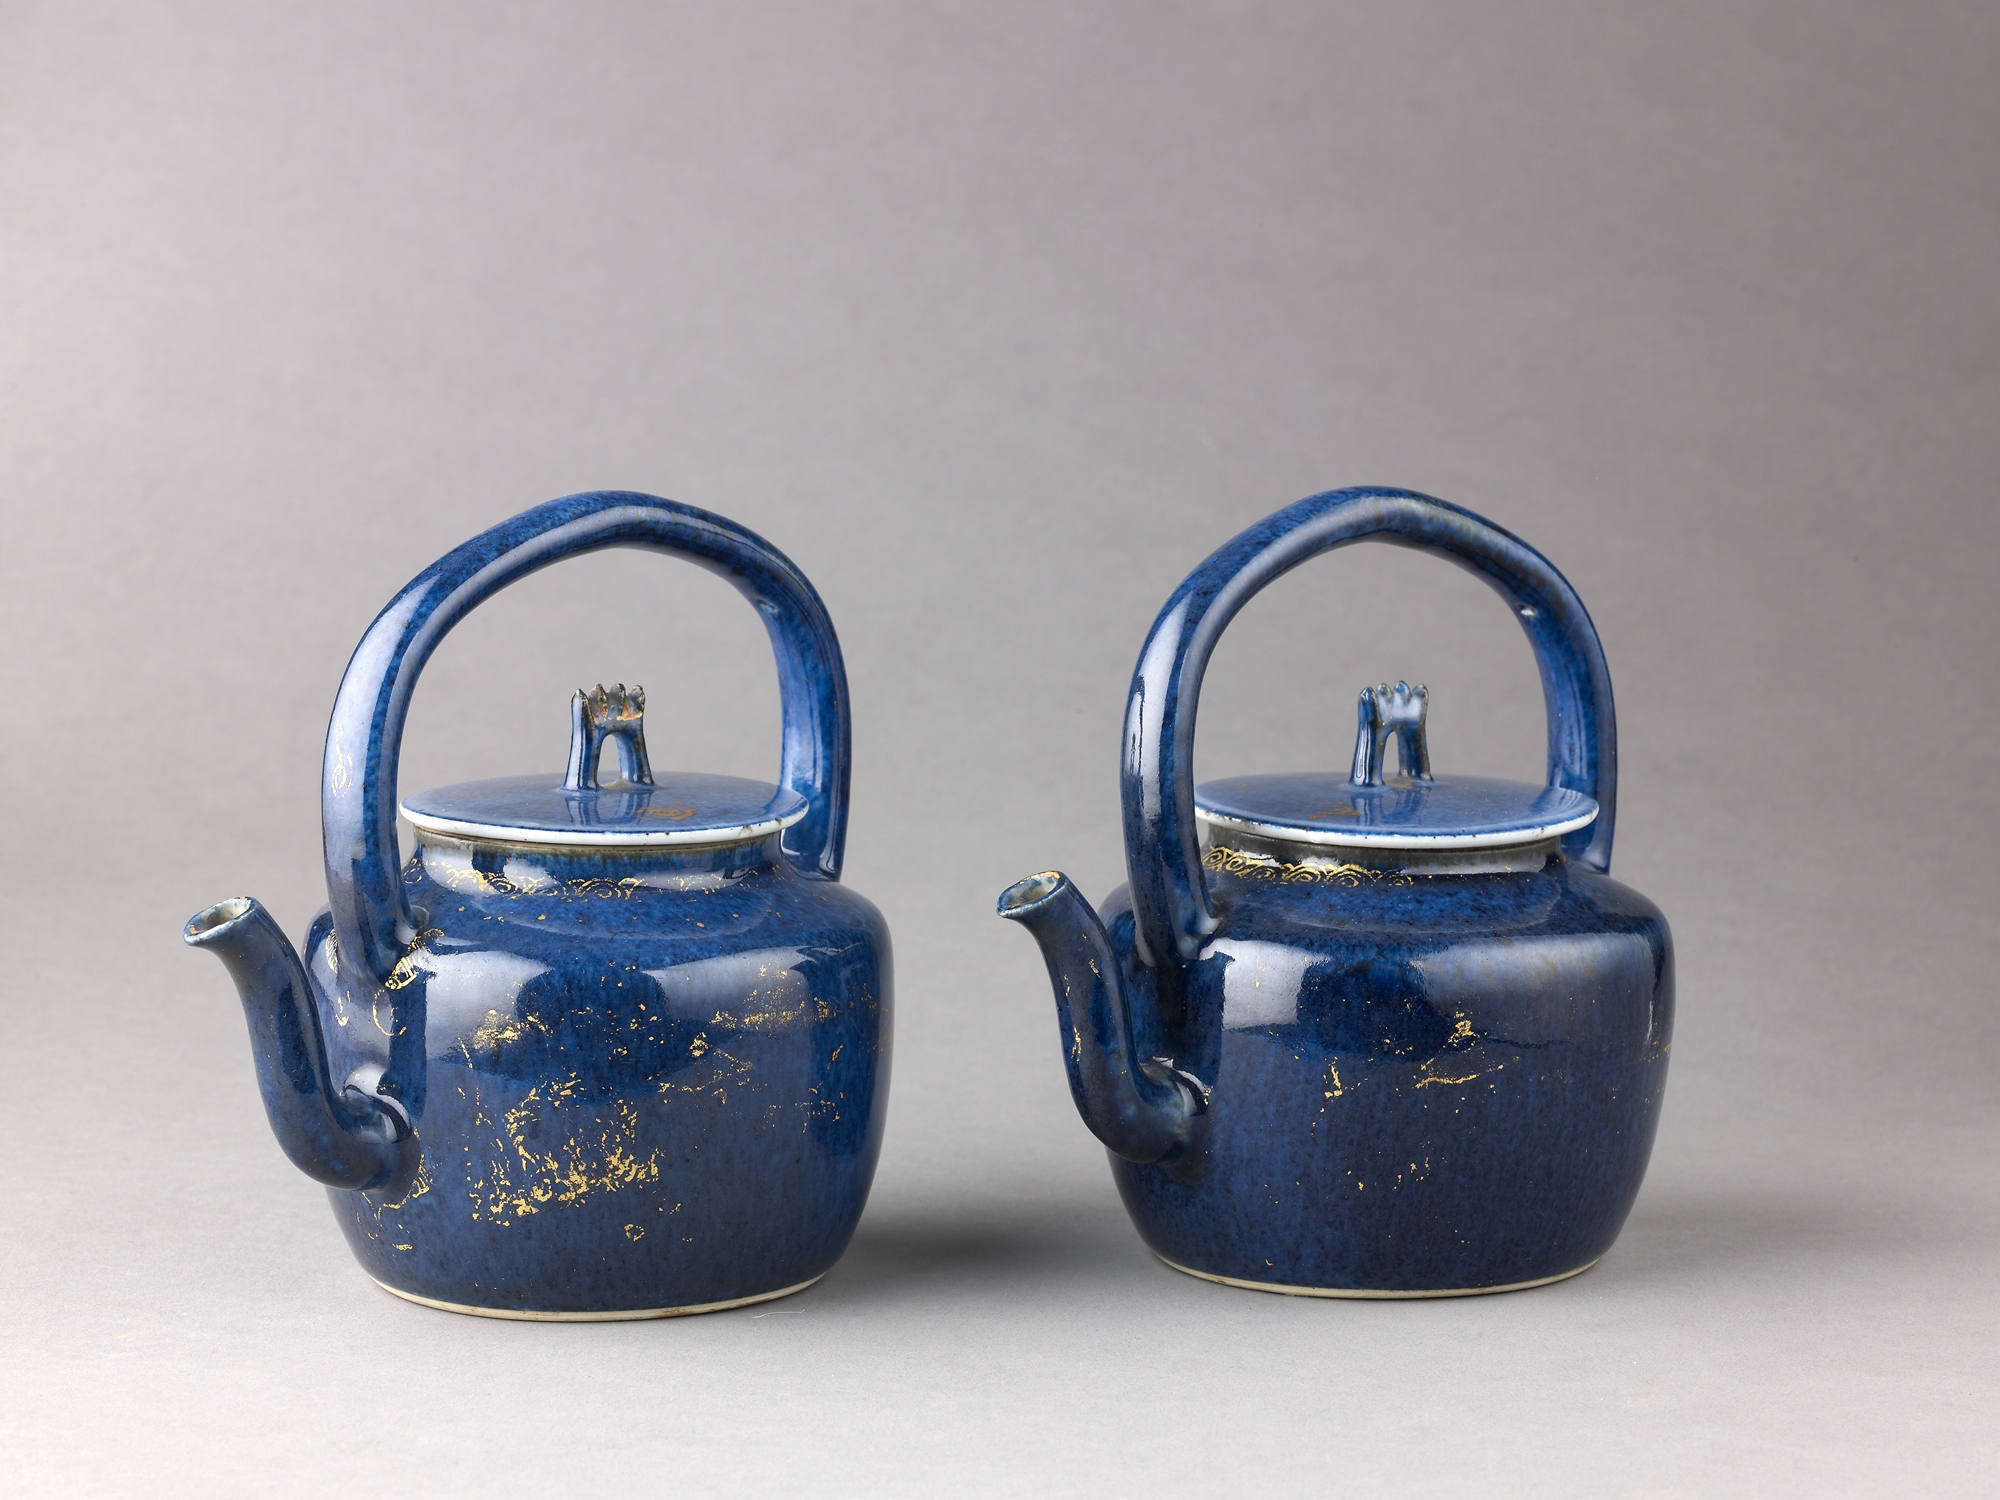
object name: covered winepot or teapot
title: Covered teapot or wine pot (pair with 1975.1.1705)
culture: chinese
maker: chinese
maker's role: artist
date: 1662-1722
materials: gilt, glaze, porcelain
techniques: overglaze, painting